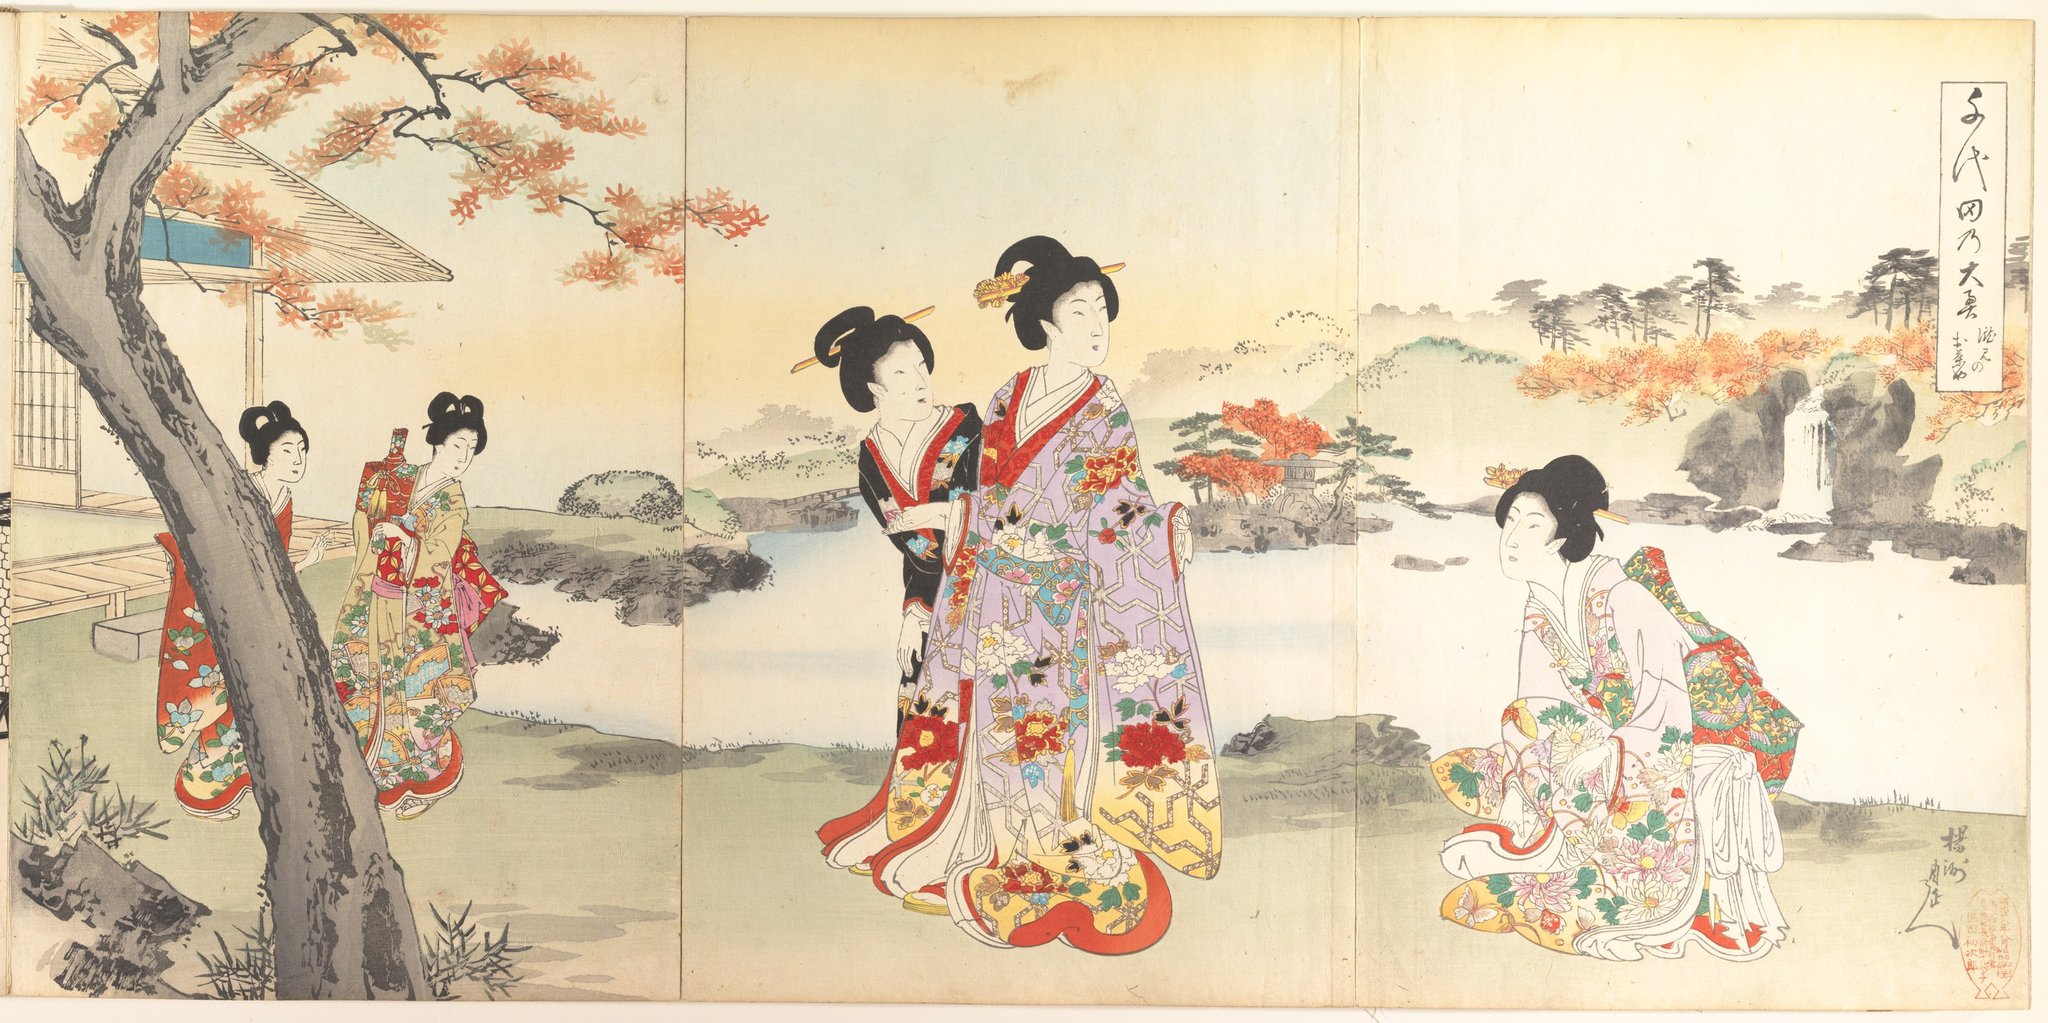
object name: print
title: Chiyoda Castle (Album of Women)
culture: japanese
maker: yōshū (hashimoto) chikanobu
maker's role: artist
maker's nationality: japanese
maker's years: 1838-1912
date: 1895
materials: ink, paper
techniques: woodblock print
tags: women,waterfalls,trees